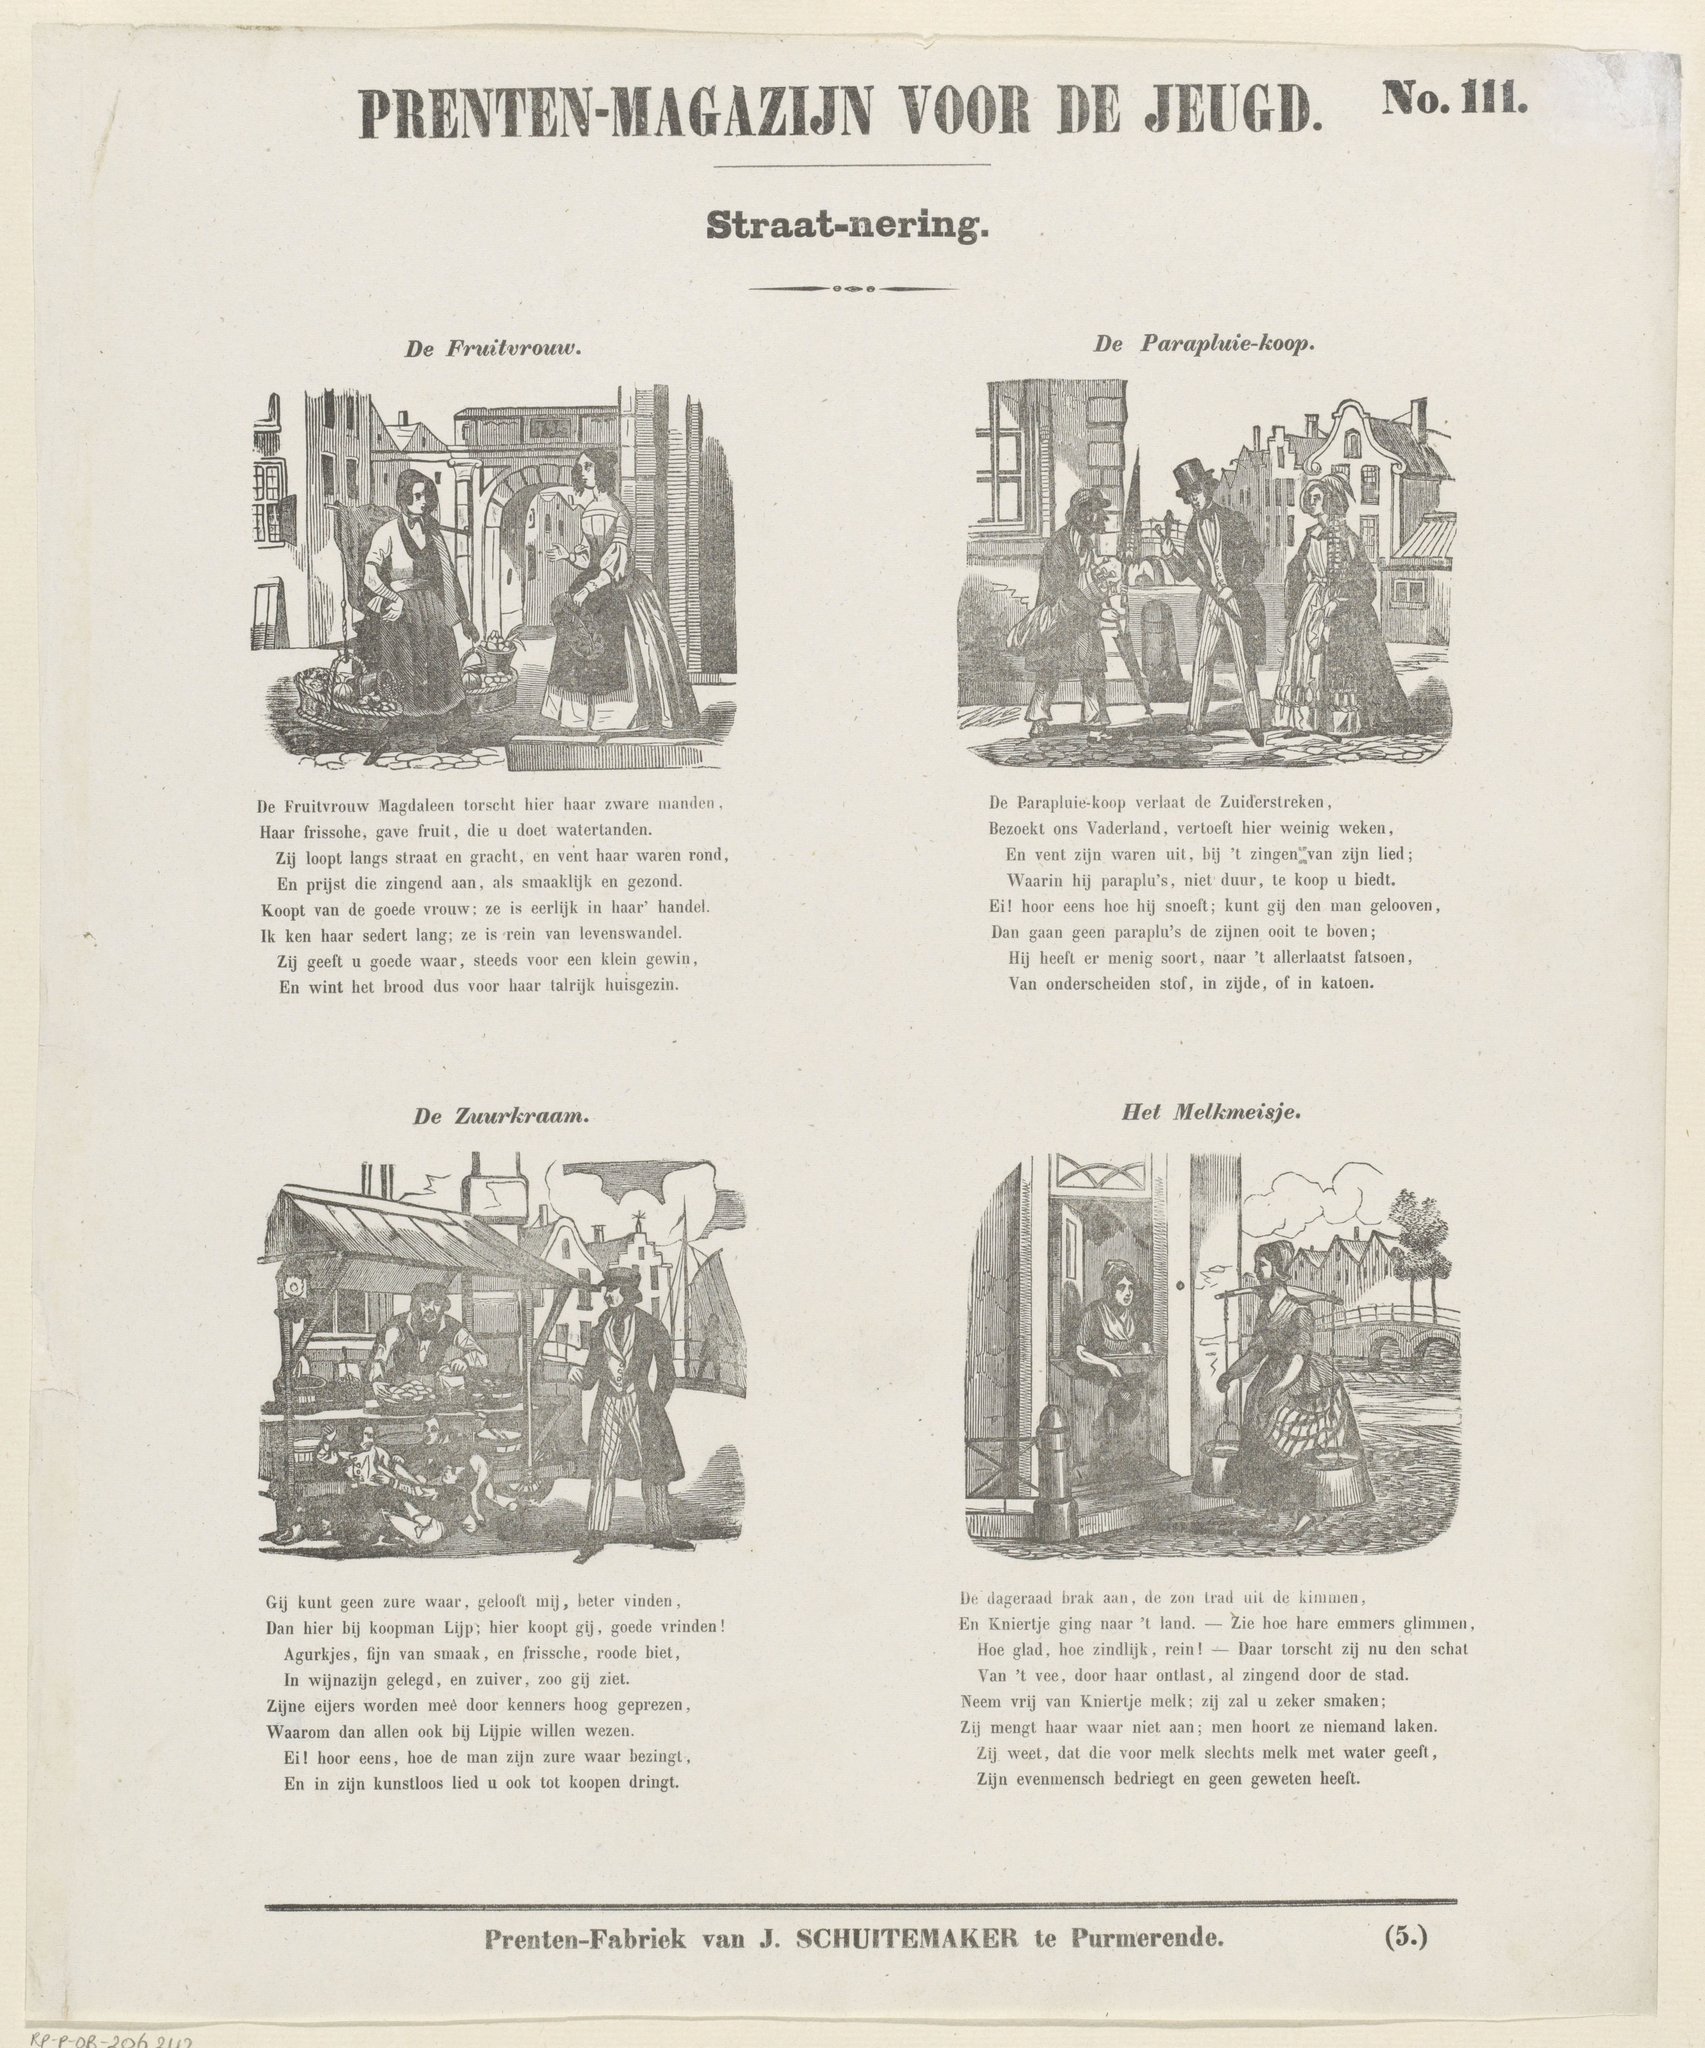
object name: print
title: Straat-nering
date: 1850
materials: paper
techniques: letterpress printing, engraving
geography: purmerend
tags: street-trader, milkmaid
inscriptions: collector's mark: Lugt 2760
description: Na voltooiing van de acht jaargangen van de reeks 'Prenten-magazijn voor de jeugd' in 1850 heeft Jan Schuitemaker al deze prenten heruitgegeven en omgenummerd als nr. 1 t/m 192. De oorspronkelijke jaargang wordt telkens nog vermeld rechtsonder op de prent. Binnen de jaargangen zijn prenten van hetzelfde thema in clusters van vier achter elkaar gezet.